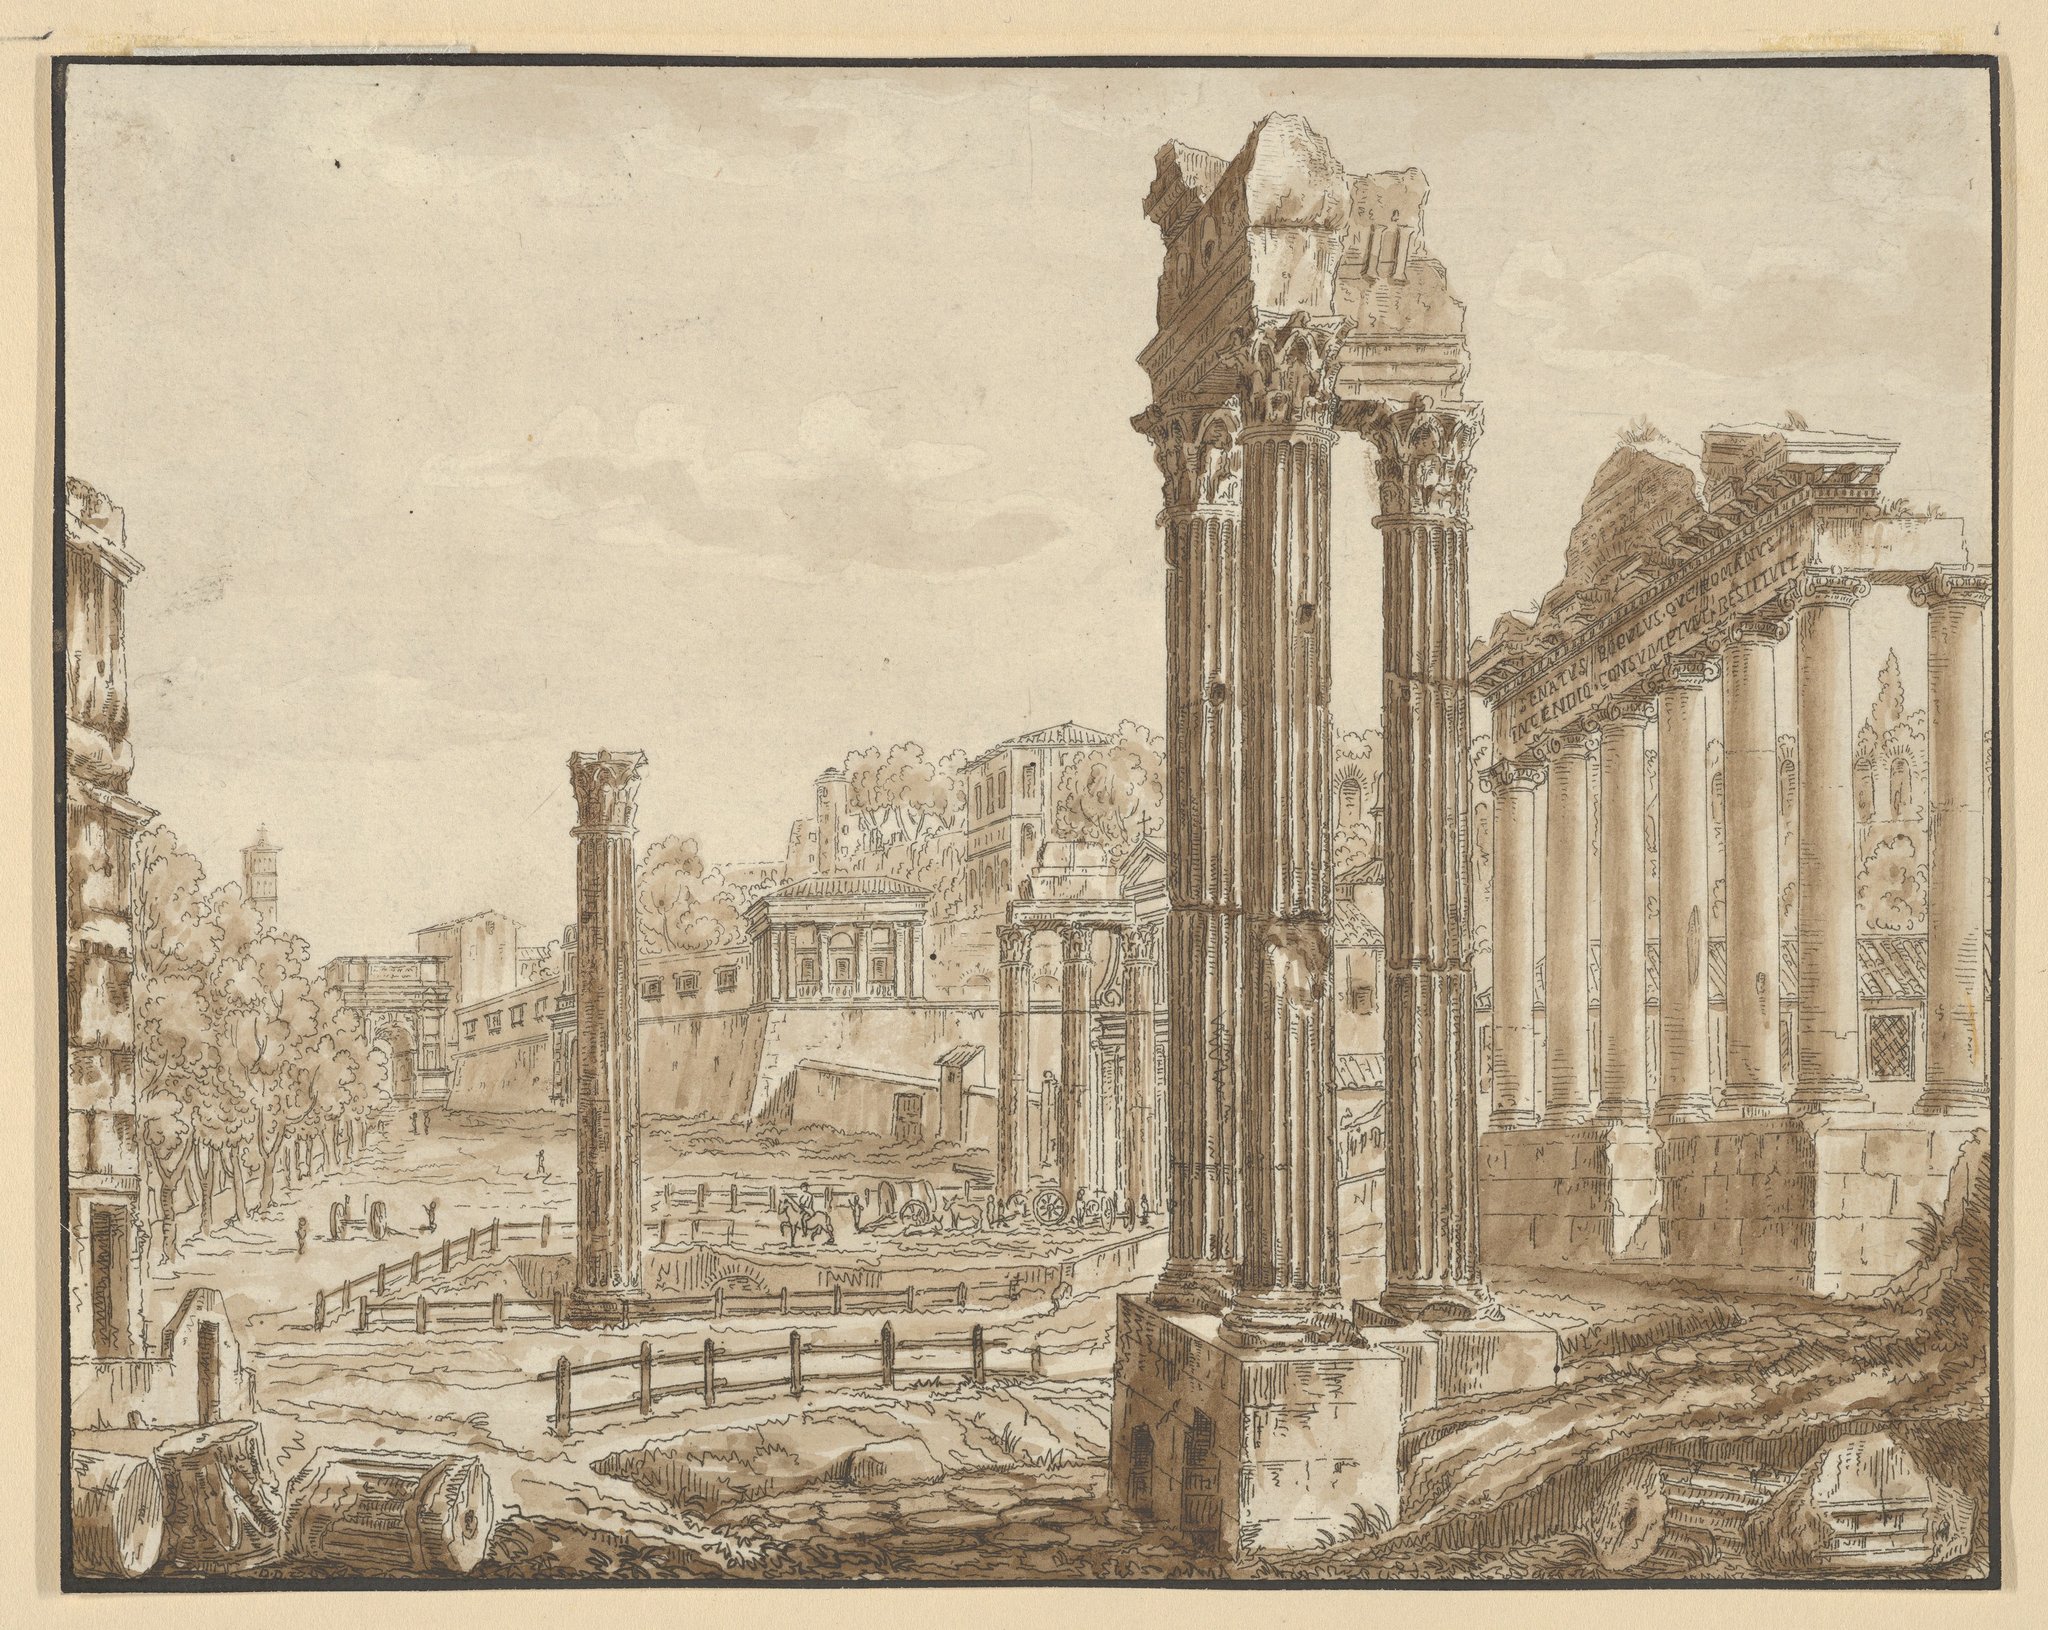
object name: drawing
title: Roman Forum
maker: anonymous, italian, 17th century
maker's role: artist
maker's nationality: italian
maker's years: 1600-1700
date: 1600-1699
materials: ink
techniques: brush, pen, wash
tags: architecture,columns,ruins